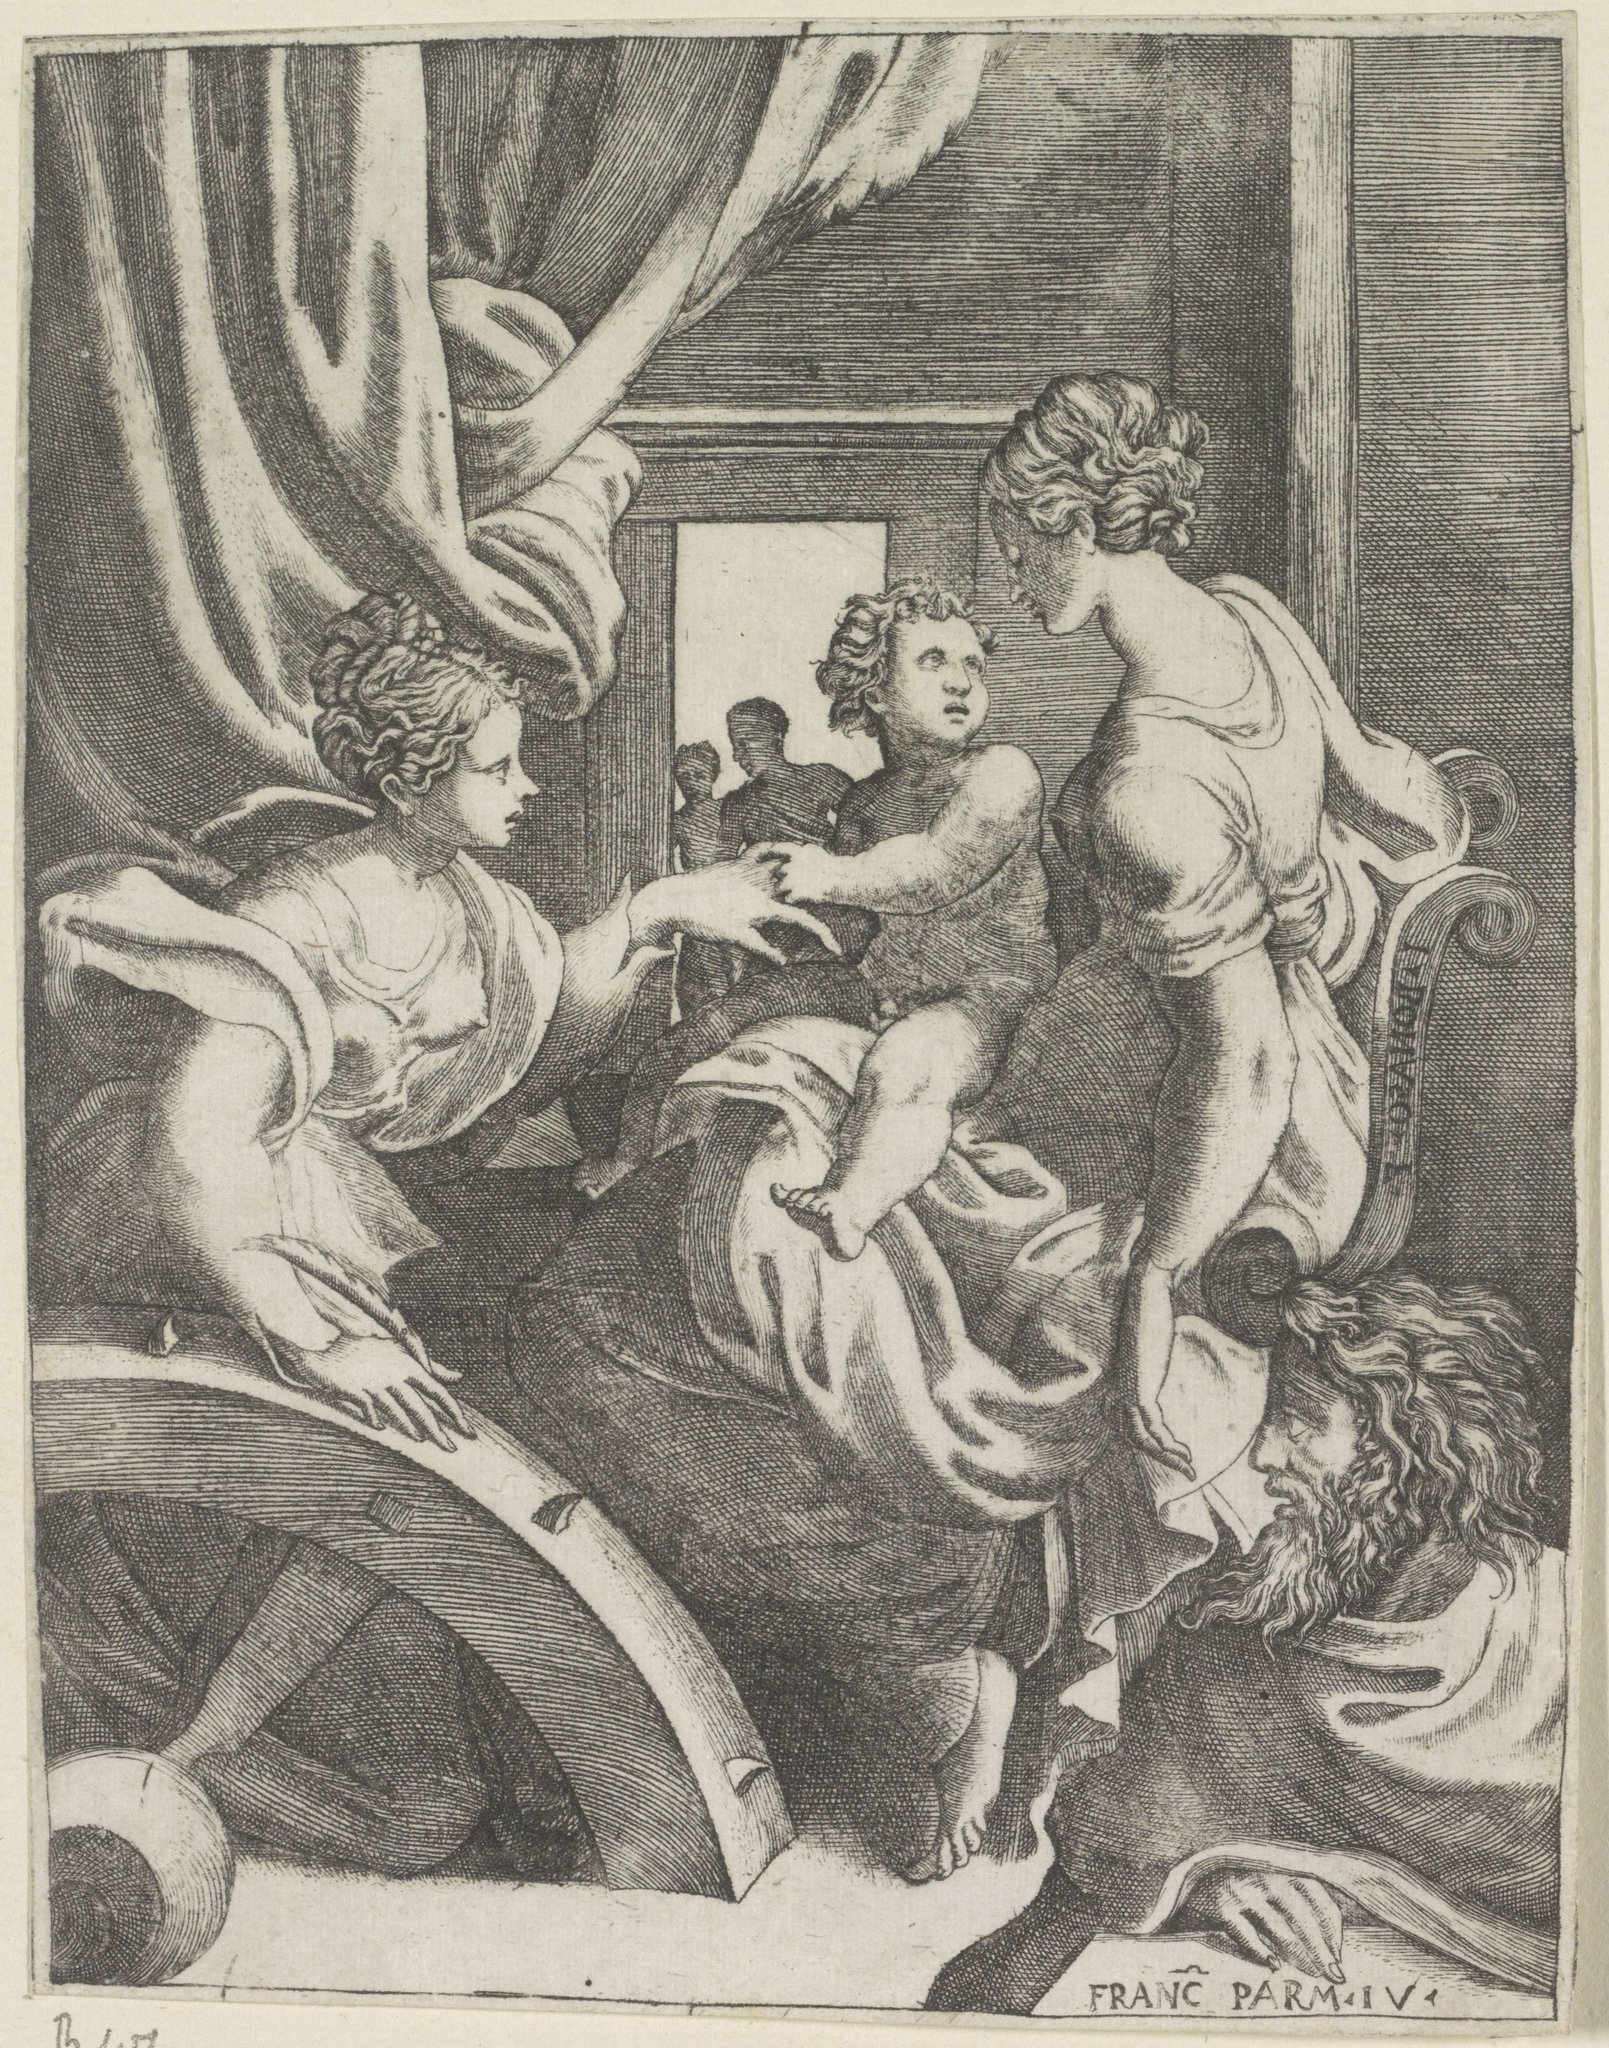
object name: print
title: Mystieke huwelijk van de heilige Catharina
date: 1501-1580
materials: paper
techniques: engraving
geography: italy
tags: the mystic marriage of st. catherine of alexandria with the infant christ: the christ-child puts a ring on her finger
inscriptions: collector's mark: Lugt 240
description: Maria zit met het Christuskind op schoot. Christus schuift een ring aan de vinger van de heilige Catharina die voor hem knielt. Op de voorgrond links een stuk van het rad van de heilige Catharina. Op de voorgrond rechts een man.